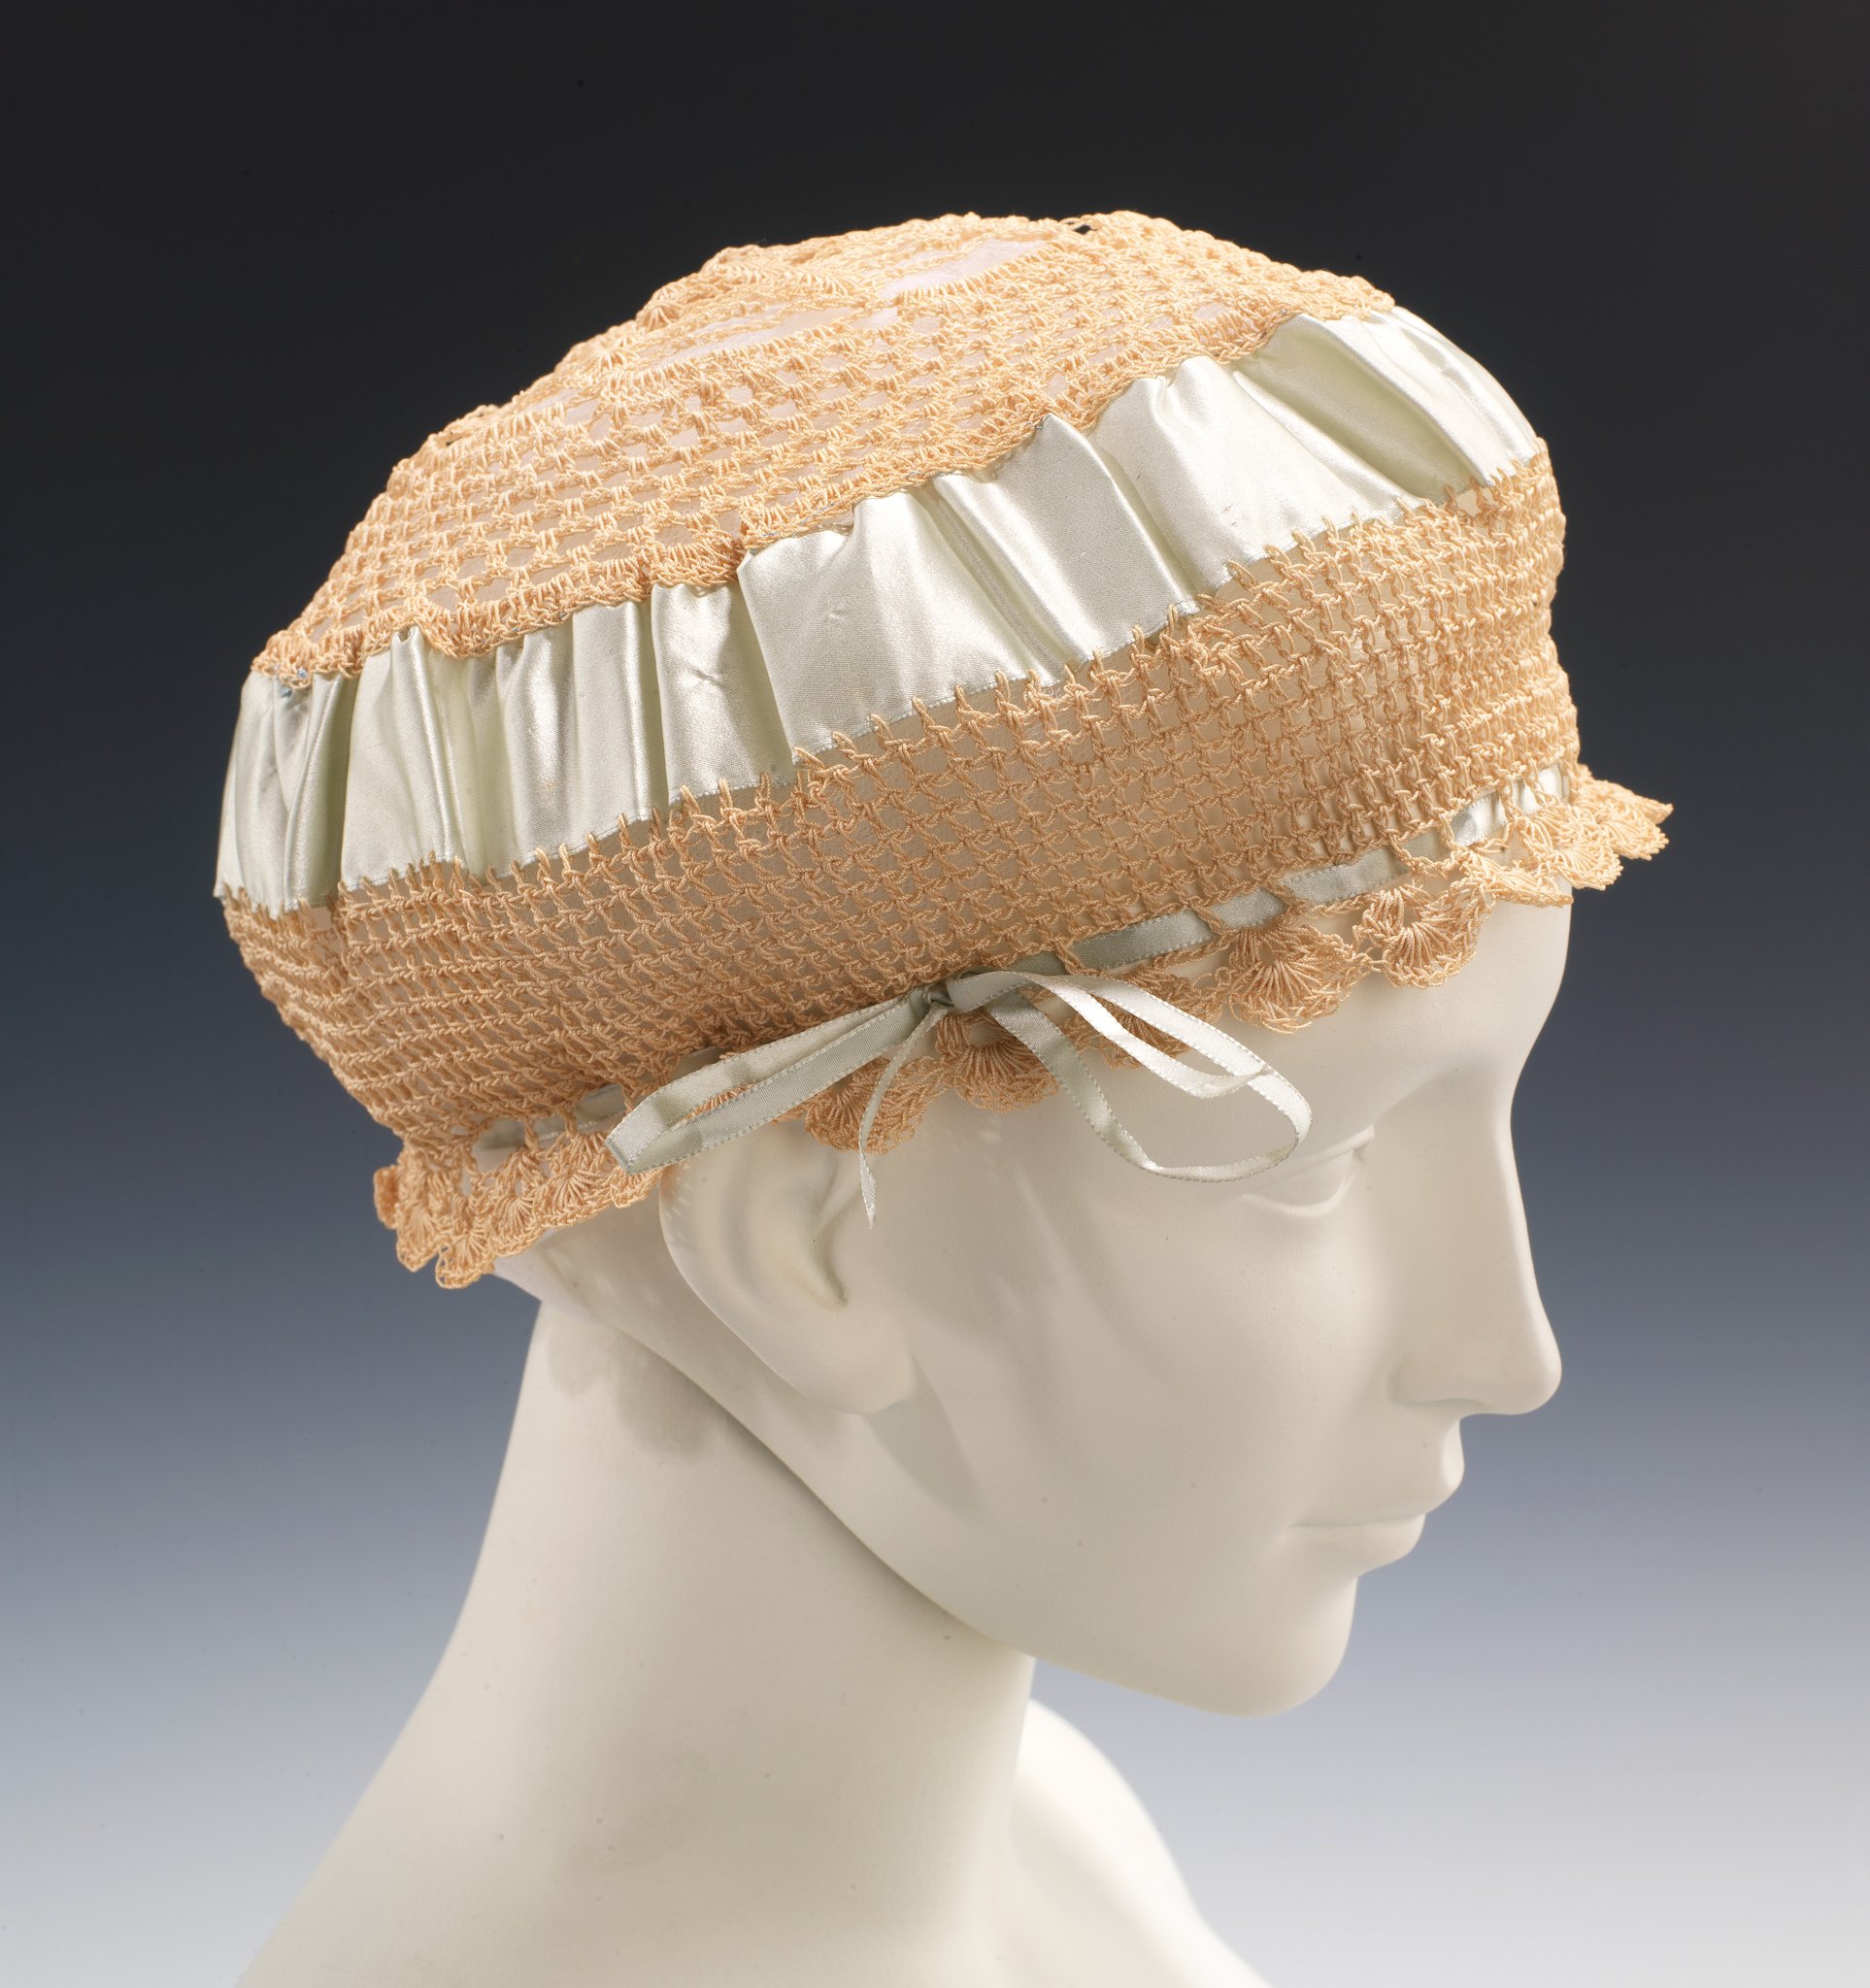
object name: boudoir cap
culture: american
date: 1895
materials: silk